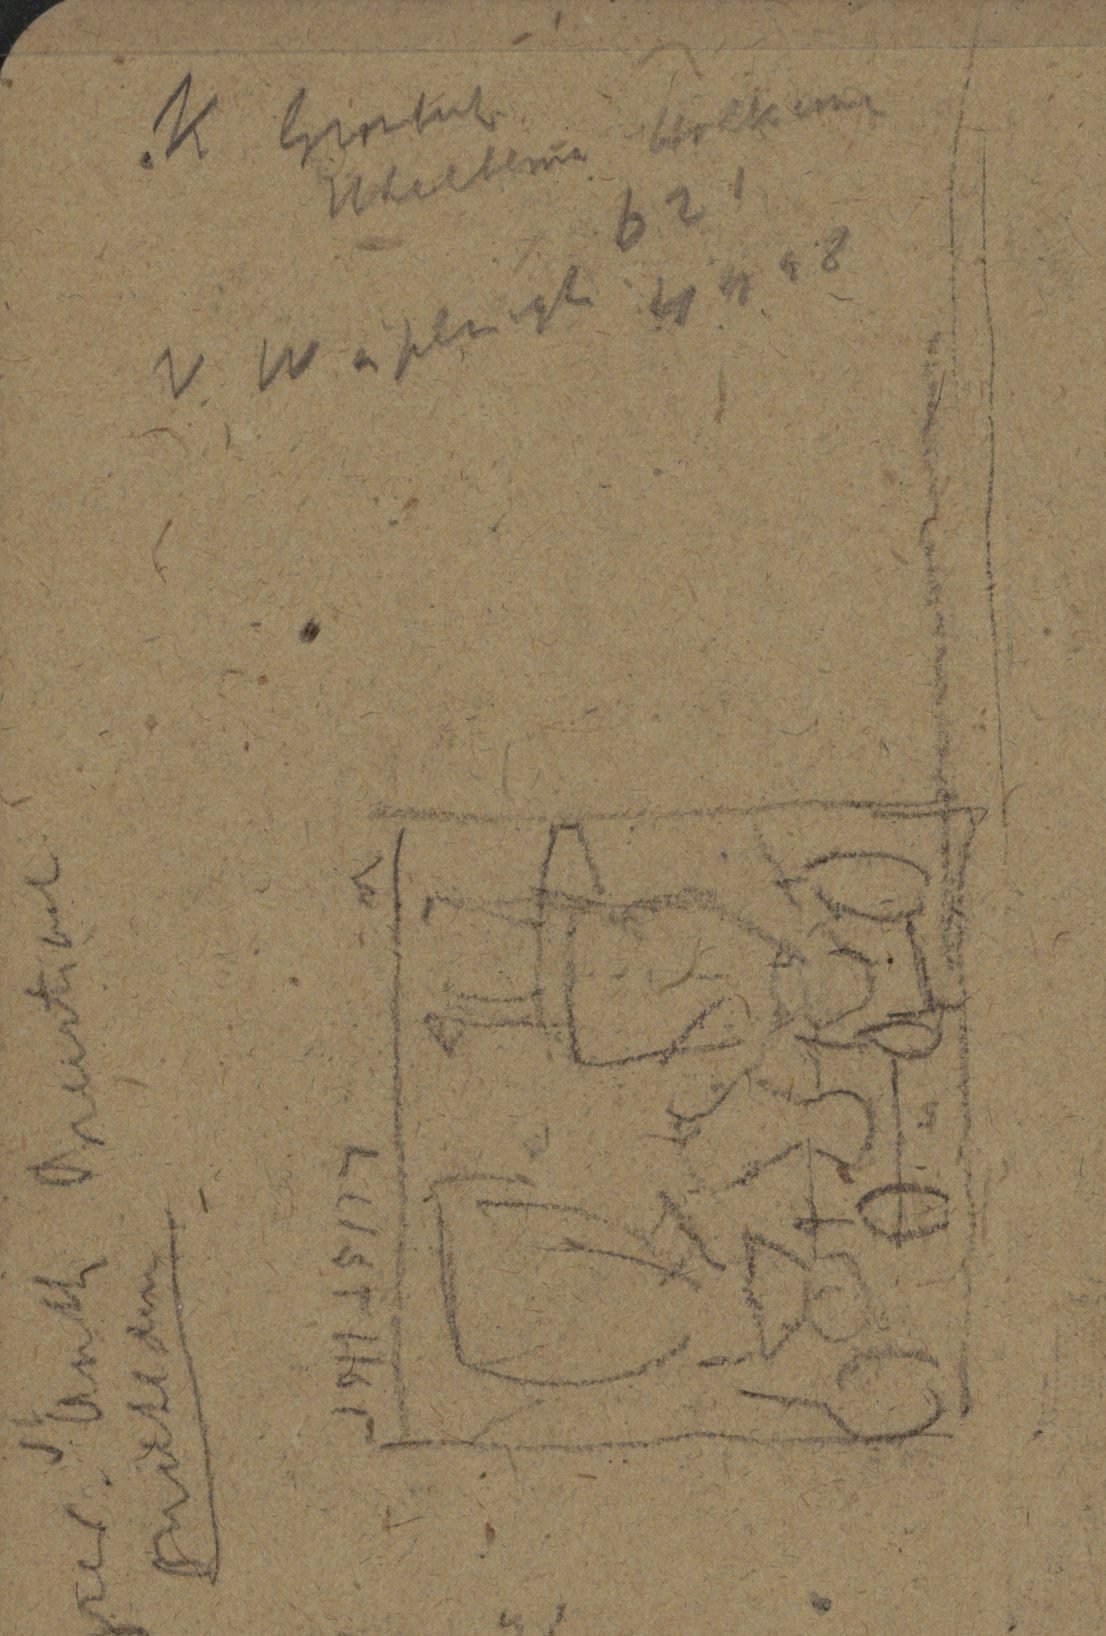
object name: endleaf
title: Compositiestudie met figuren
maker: george hendrik breitner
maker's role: draughtsman, painter, print maker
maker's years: 1857-1923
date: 1903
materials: chalk, paper, pencil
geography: amsterdam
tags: adult woman, adult man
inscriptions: annotation: ‘[...]/ W. Lusthof[?]/ [...]’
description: Pagina 1, voorste schutblad, uit een schetsboek met 32 bladen.